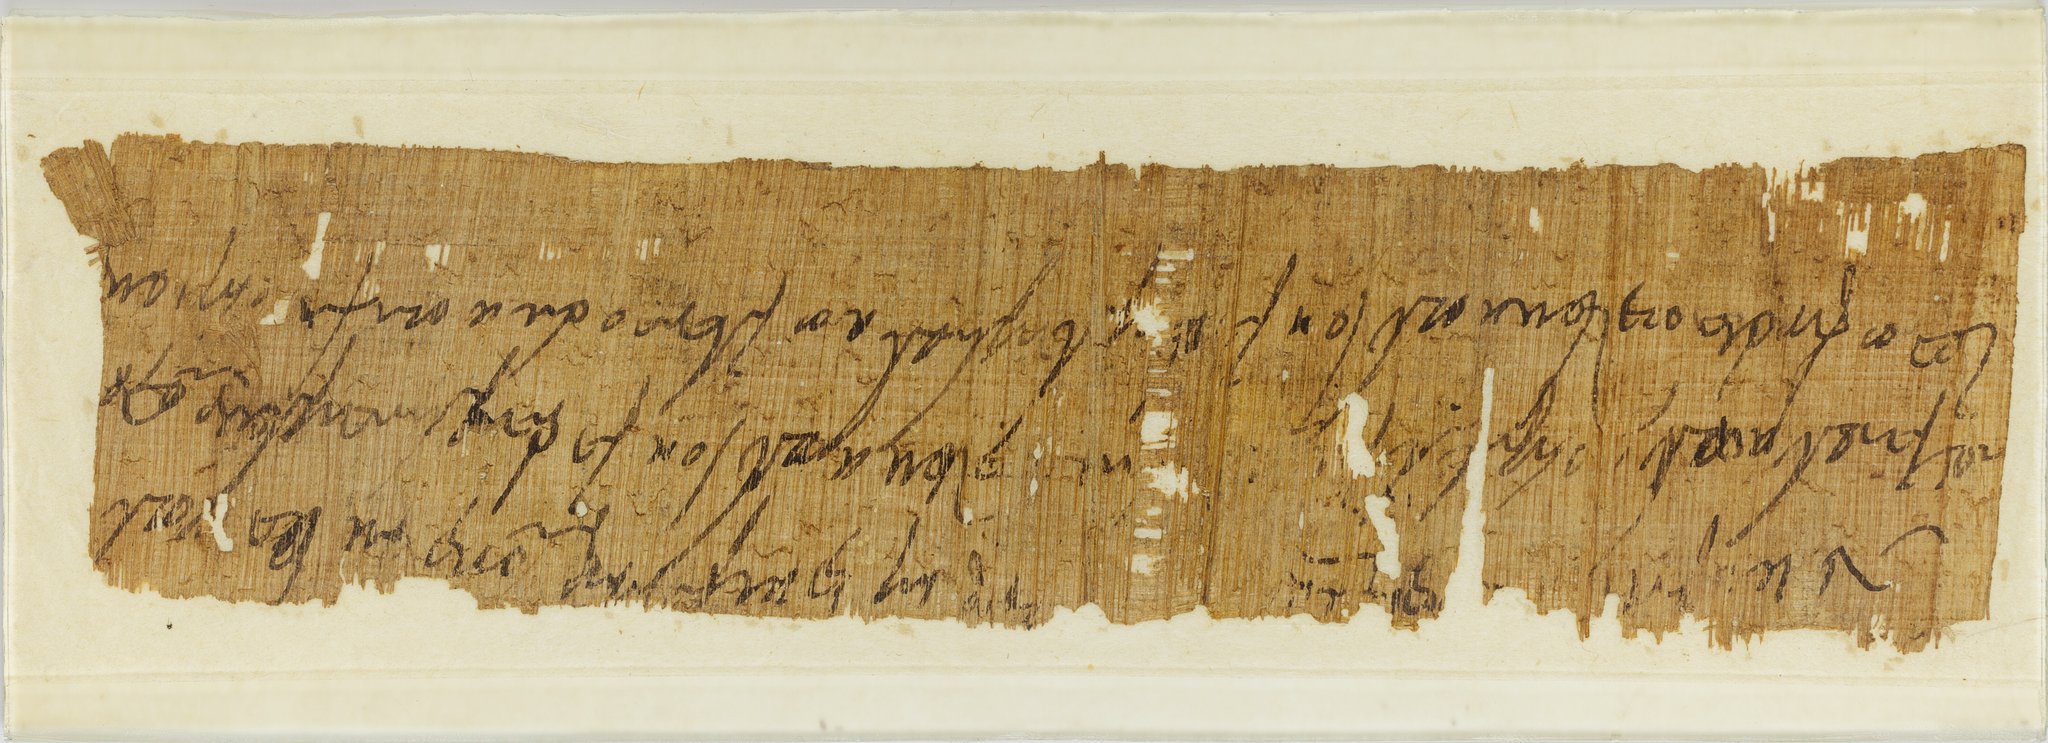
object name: papyrus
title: Papyrus fragment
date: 301-400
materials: ink, papyrus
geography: egypt